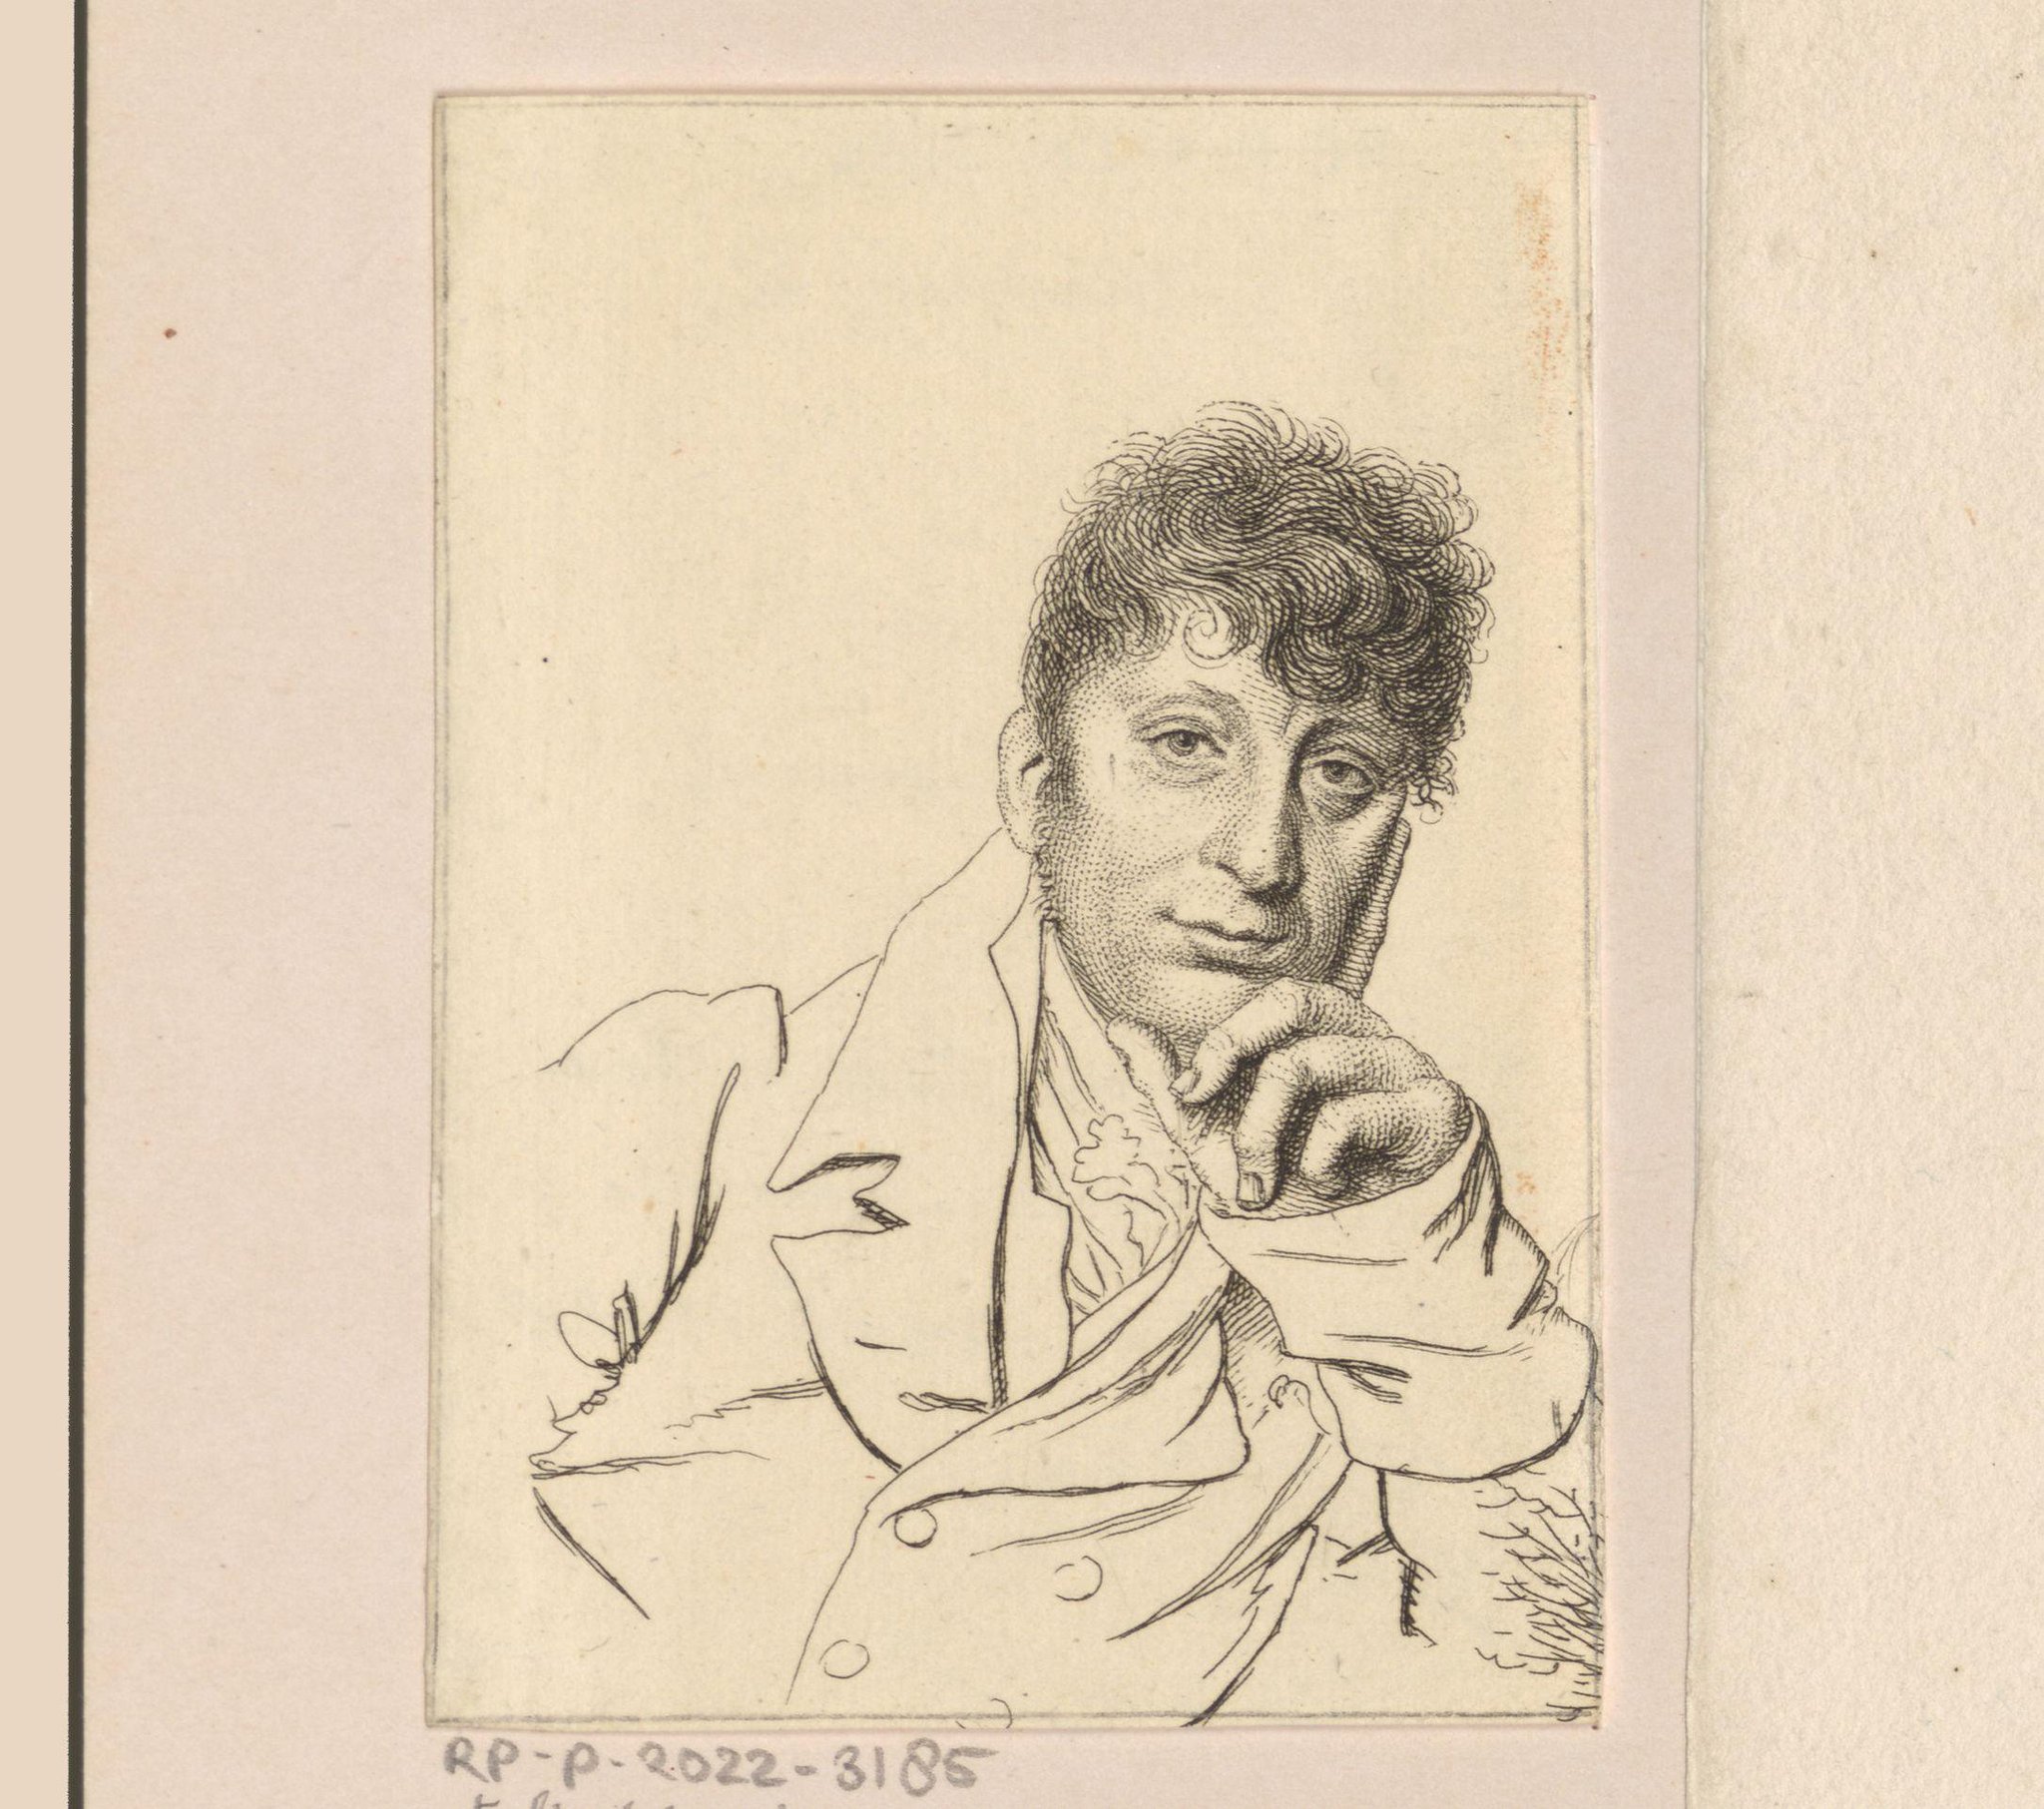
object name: print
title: Portret van Hendrik Stokvisch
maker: jacob ernst marcus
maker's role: draughtsman, print maker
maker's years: 1774-1826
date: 1803-1811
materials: paper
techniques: etching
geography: amsterdam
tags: painter, hendrik stokvisch, historical persons, portrait, self-portrait of artist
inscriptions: collector's mark: Lugt 924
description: Serie voor het eerst uitgegeven door Jacob Ernst Marcus onder de titel Studiebeelden en Fragmenten. Amsterdam: ca.1816. Later heruitgegeven als: Studie-prentwerk/ Etudes gravées.